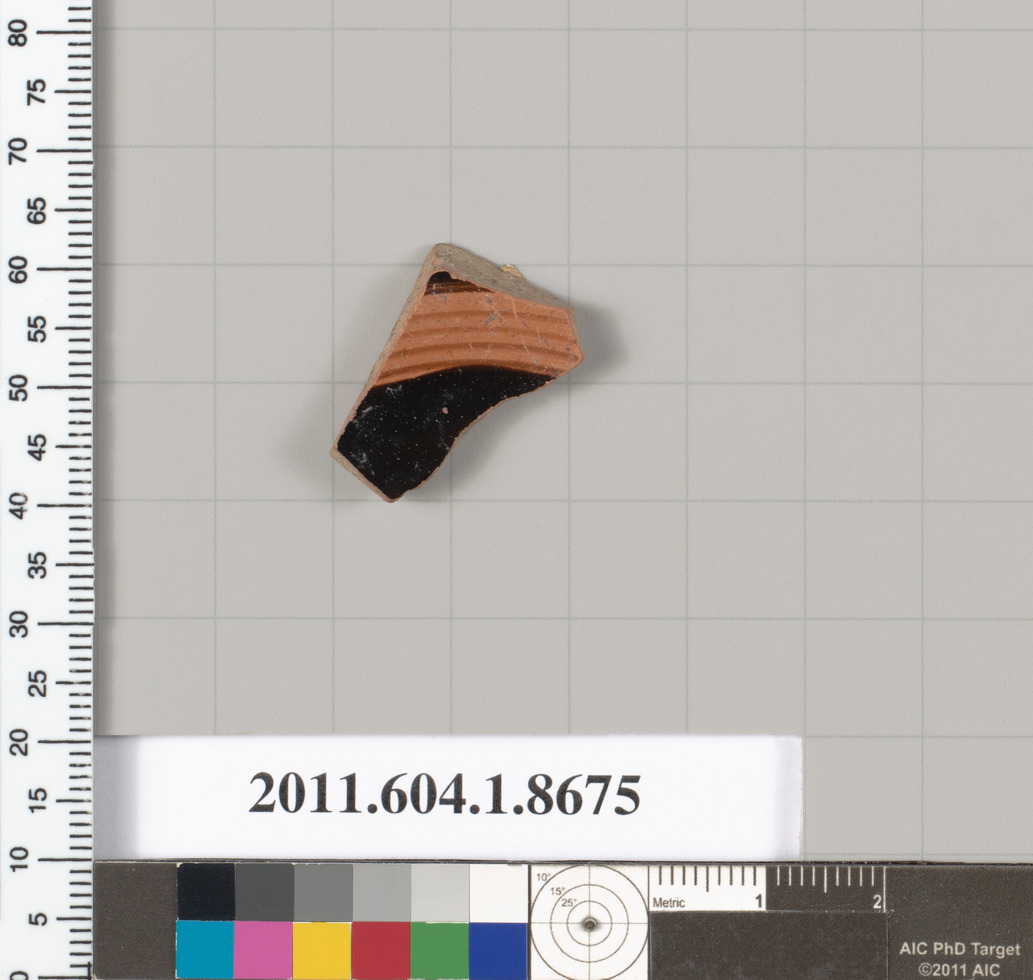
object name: kylix fragment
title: Terracotta fragment of a stemless kylix (drinking cup)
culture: greek, attic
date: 467-435 BCE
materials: terracotta